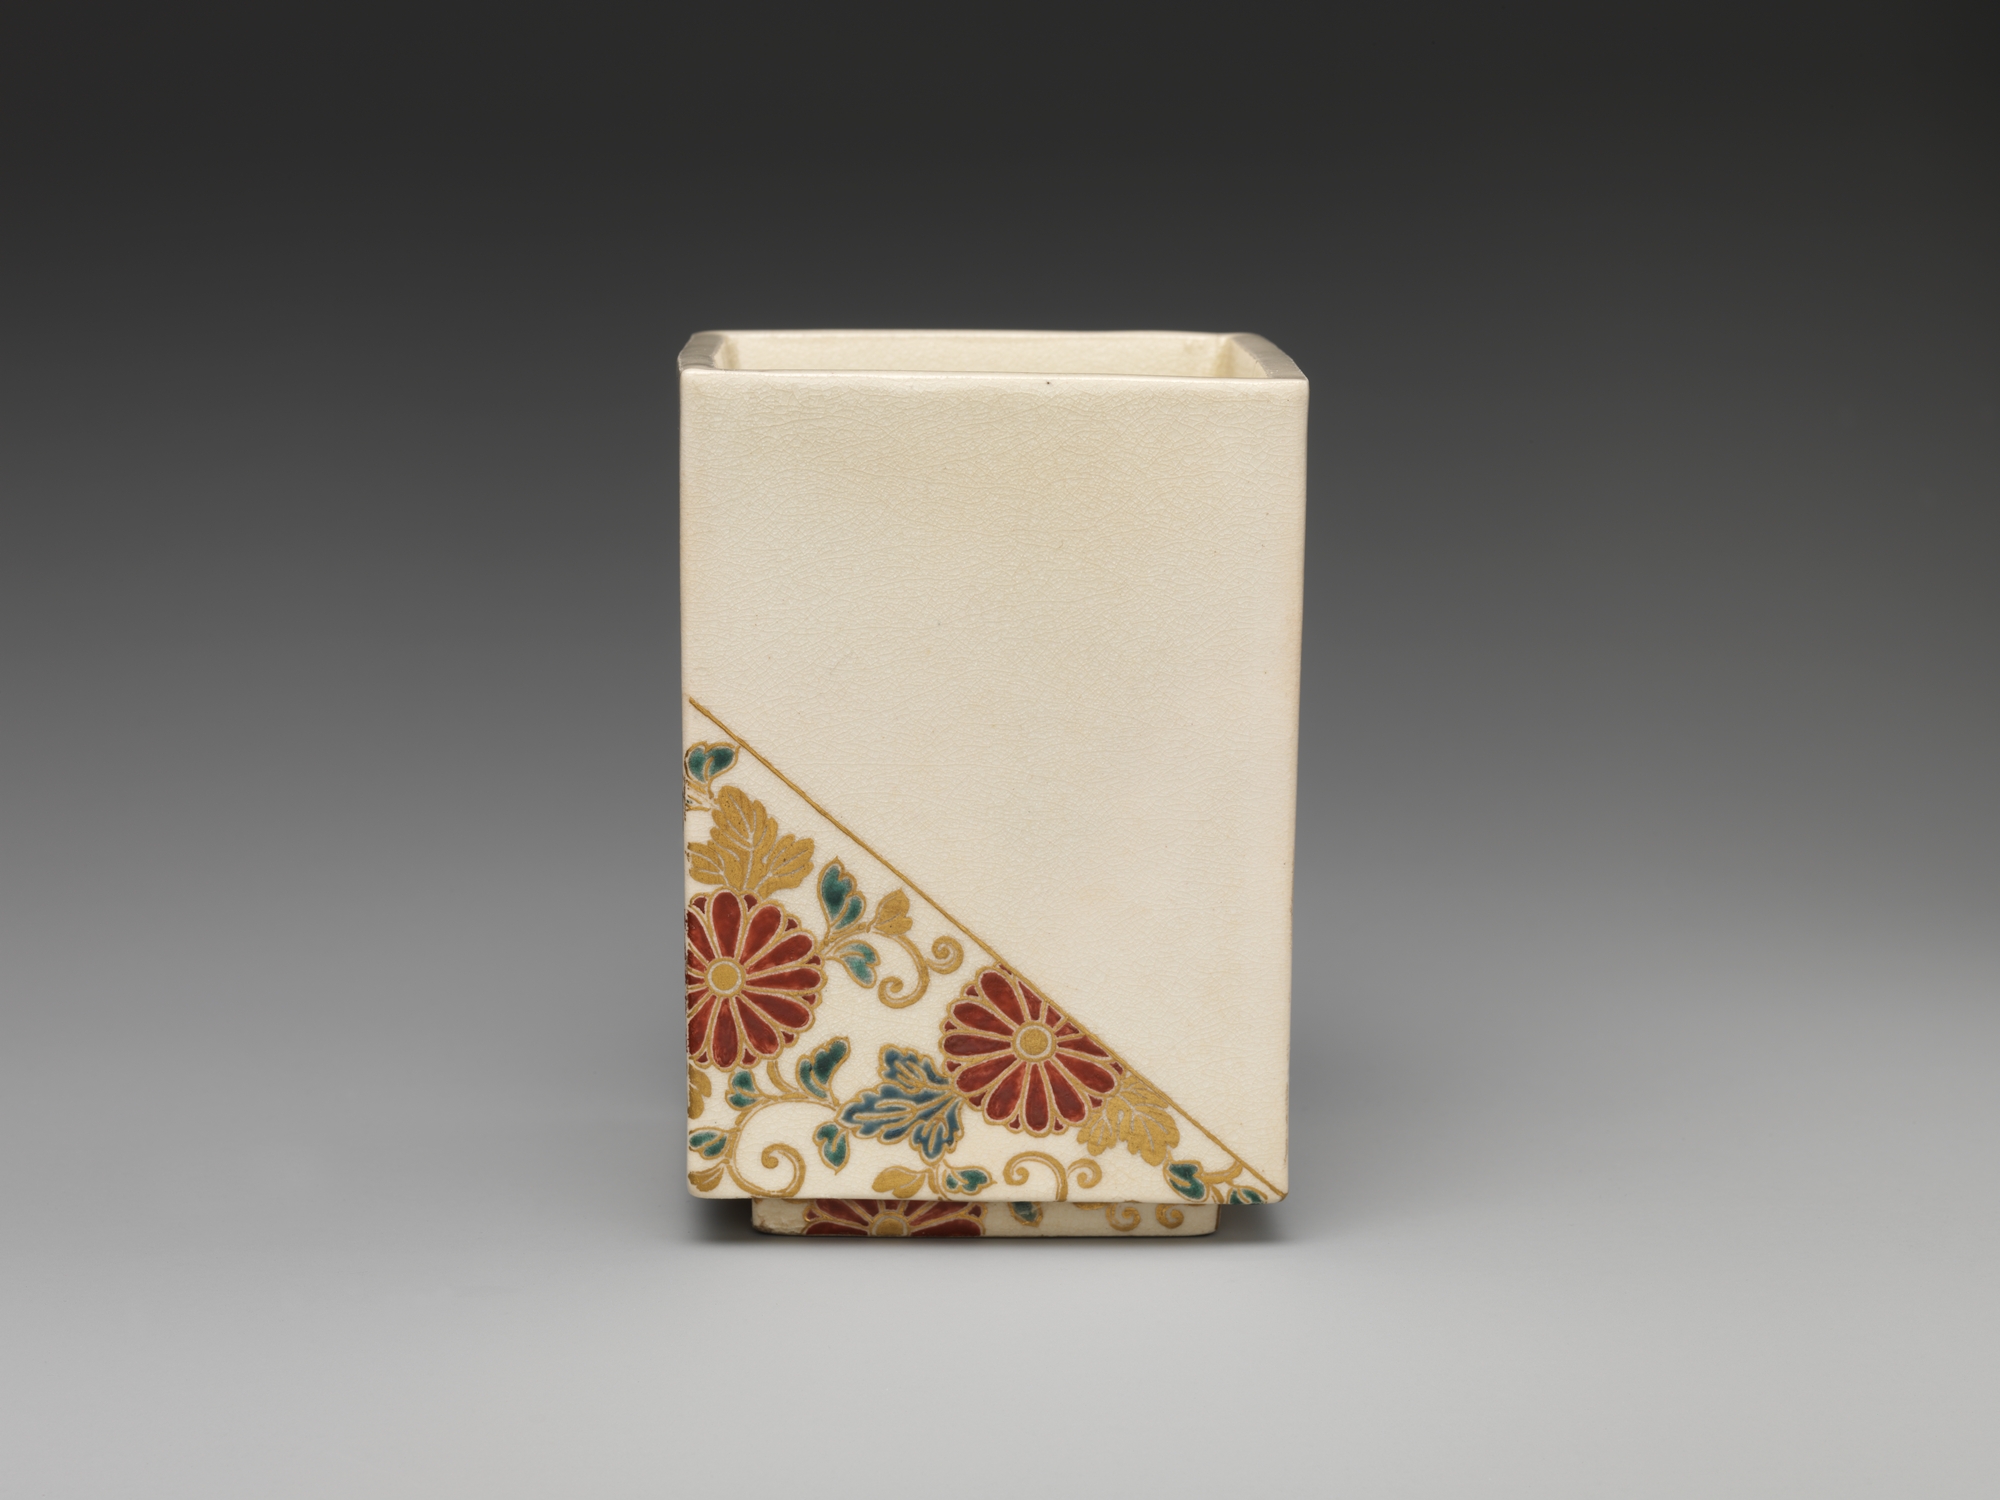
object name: container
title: Ninsei-style Serving Containers (Mukōzuke)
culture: japanese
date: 1868-1912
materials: enamel, stoneware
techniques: overglaze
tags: flowers